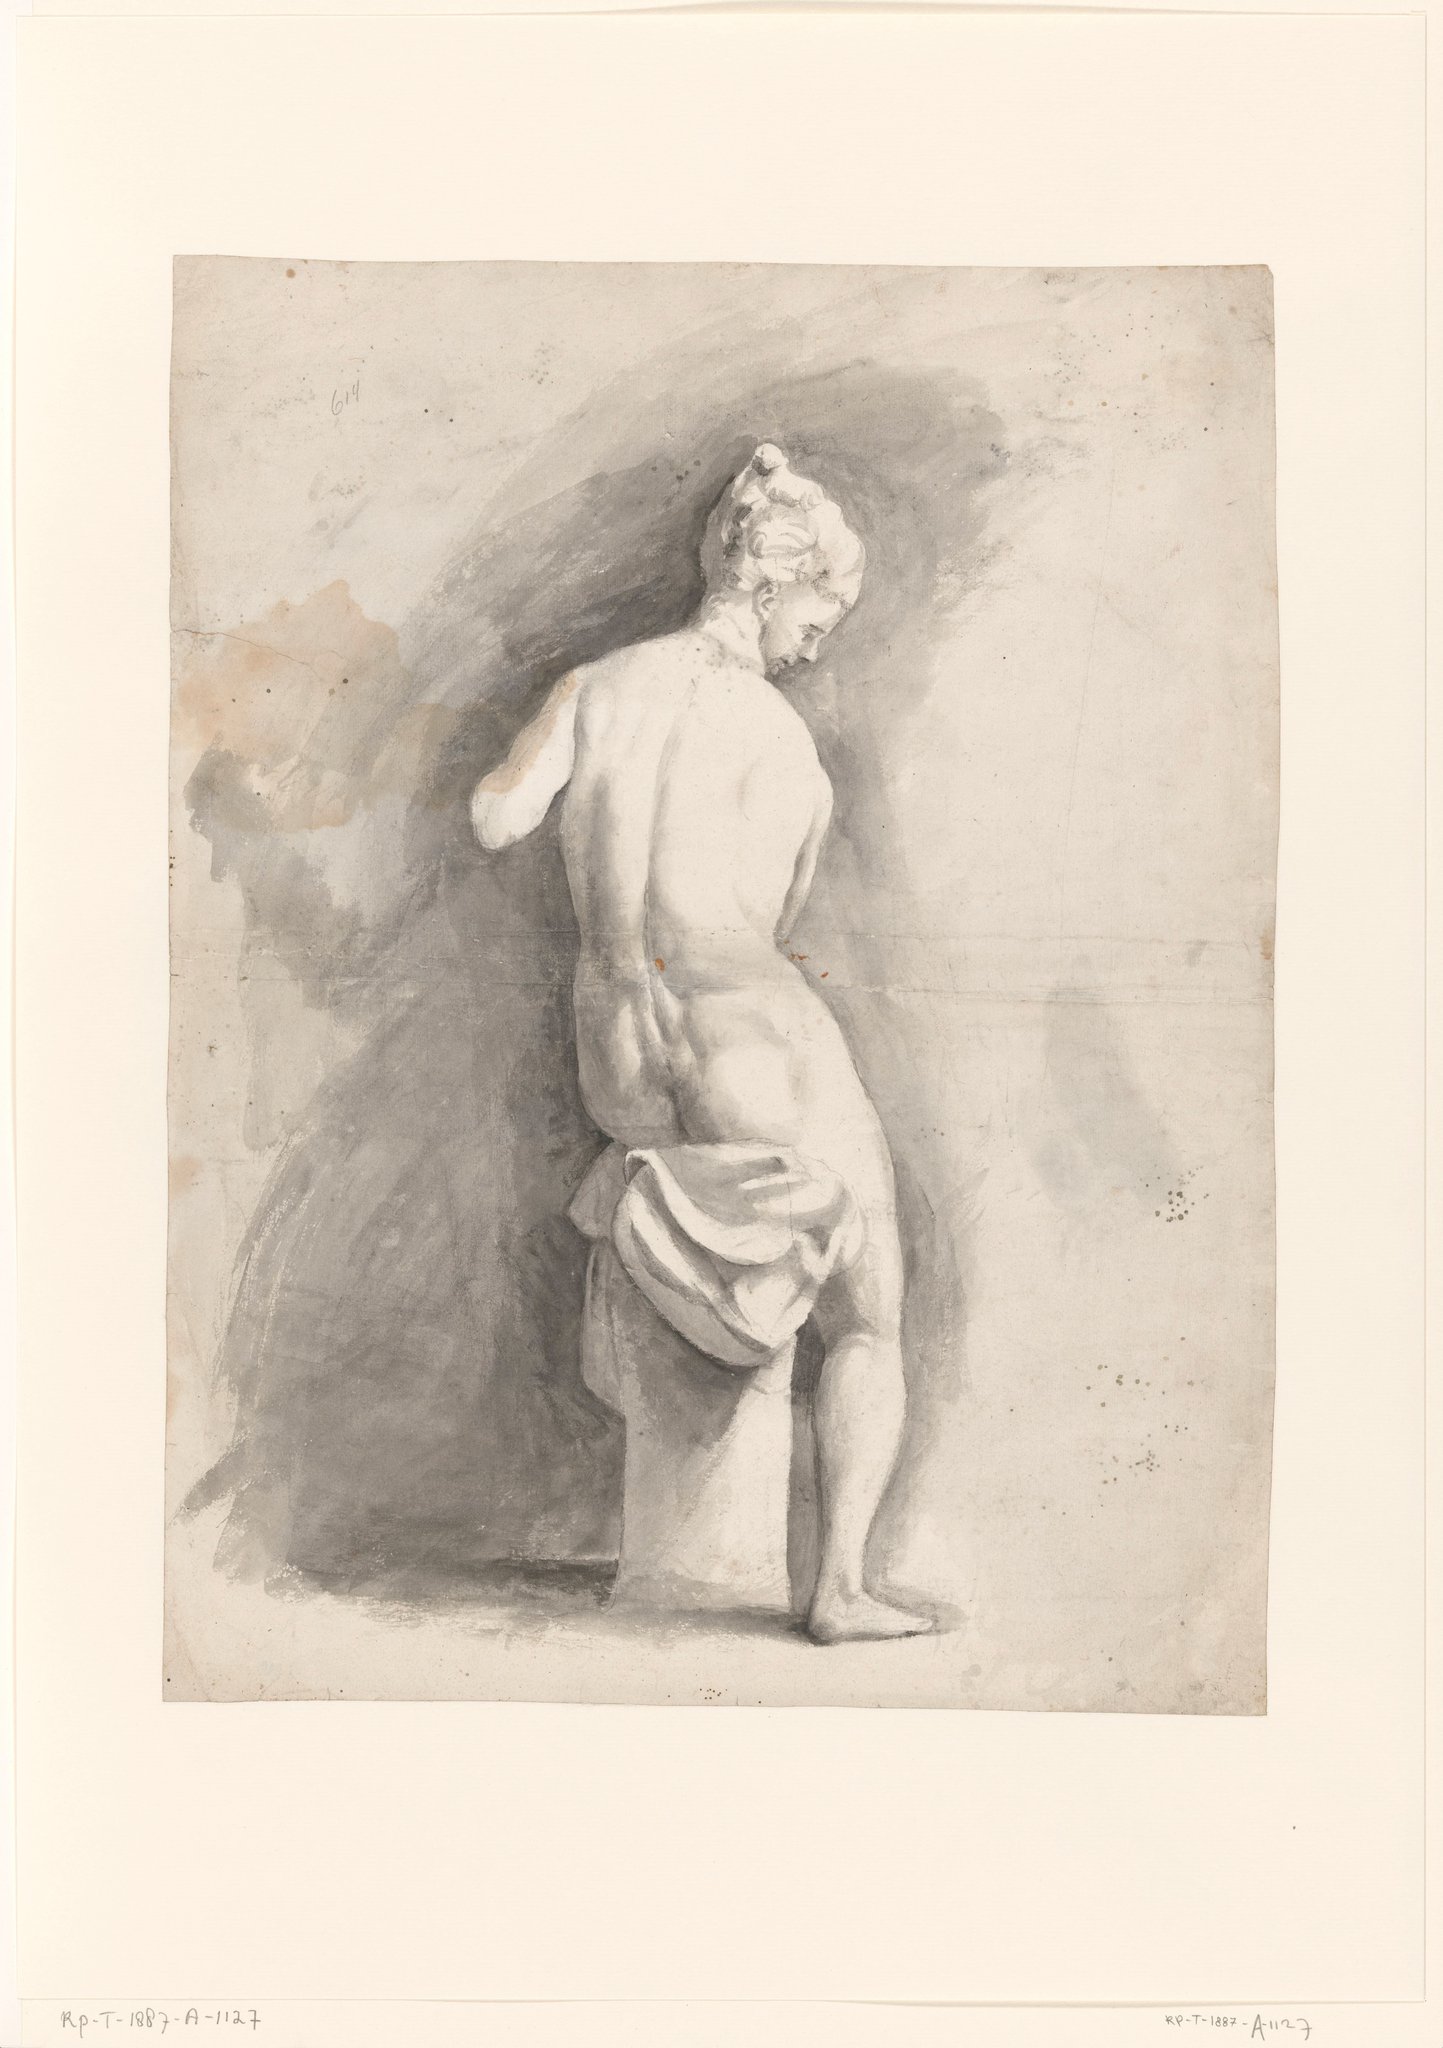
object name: drawing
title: Beeld van zittende naakte vrouw, van achteren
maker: moses ter borch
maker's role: draughtsman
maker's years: 1645-1667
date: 1657-1658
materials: chalk, ink, paper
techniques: brush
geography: zwolle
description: Het afgietsel dat Moses heeft getekend was gebaseerd op een antieke sculptuur gerelateerd aan de 'Venus die haar sandaal omdoet' of waarschijnlijker aan het bronzen beeld van Giovanni da Bologna, 'Badende vrouw'.